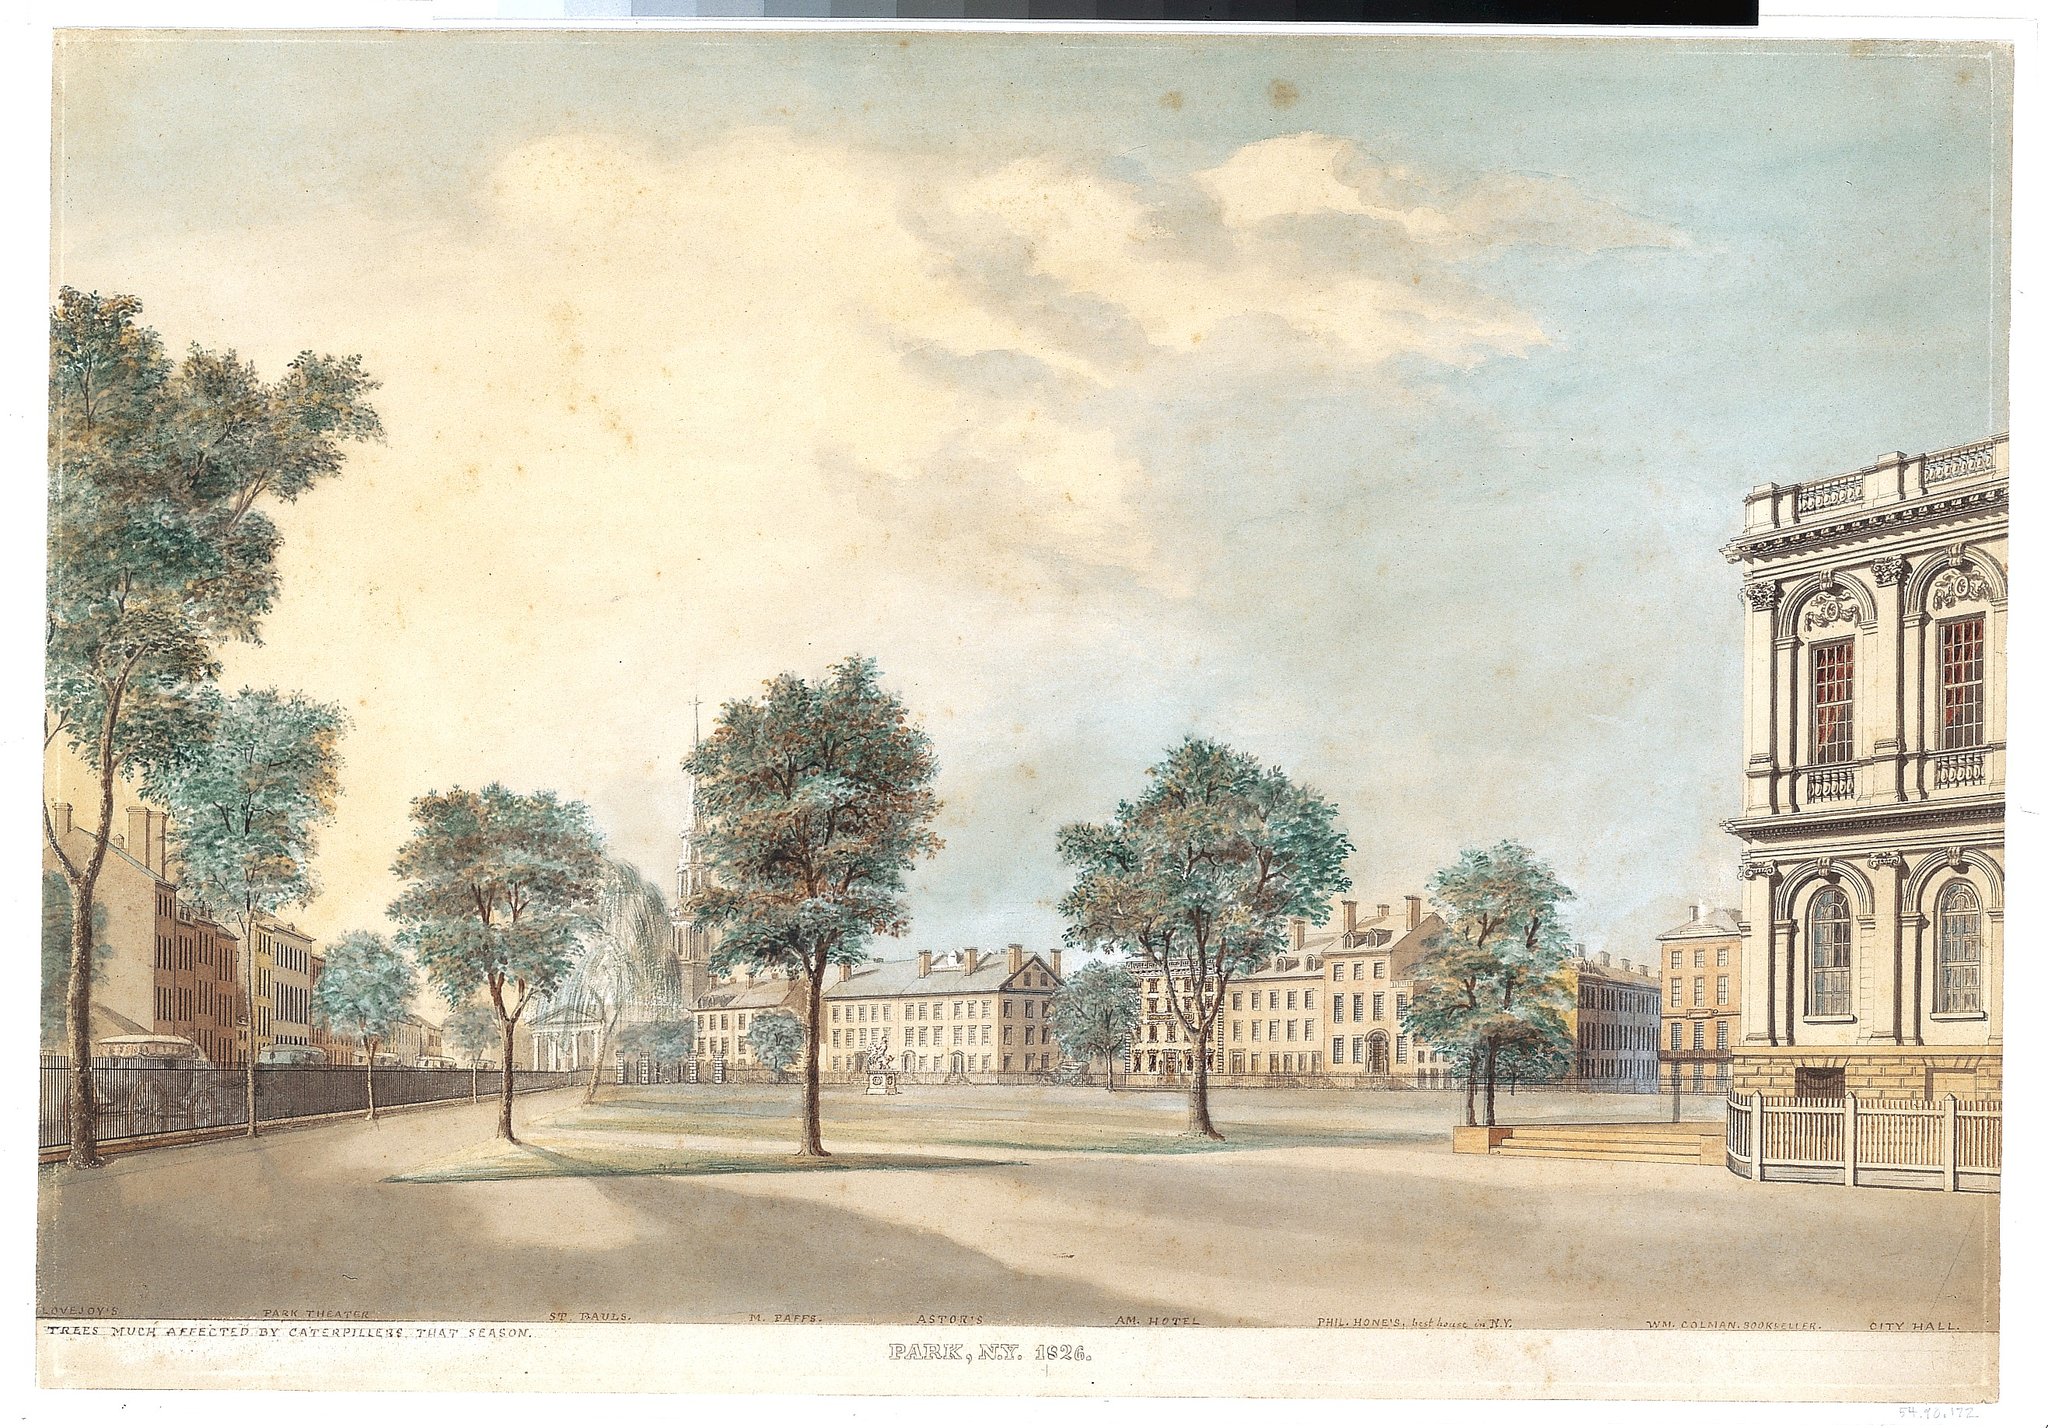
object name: drawing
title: City Hall Park, New York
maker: alexander jackson davis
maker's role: artist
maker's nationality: american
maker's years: 1803-1892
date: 1826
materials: ink, watercolor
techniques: heightening, pen